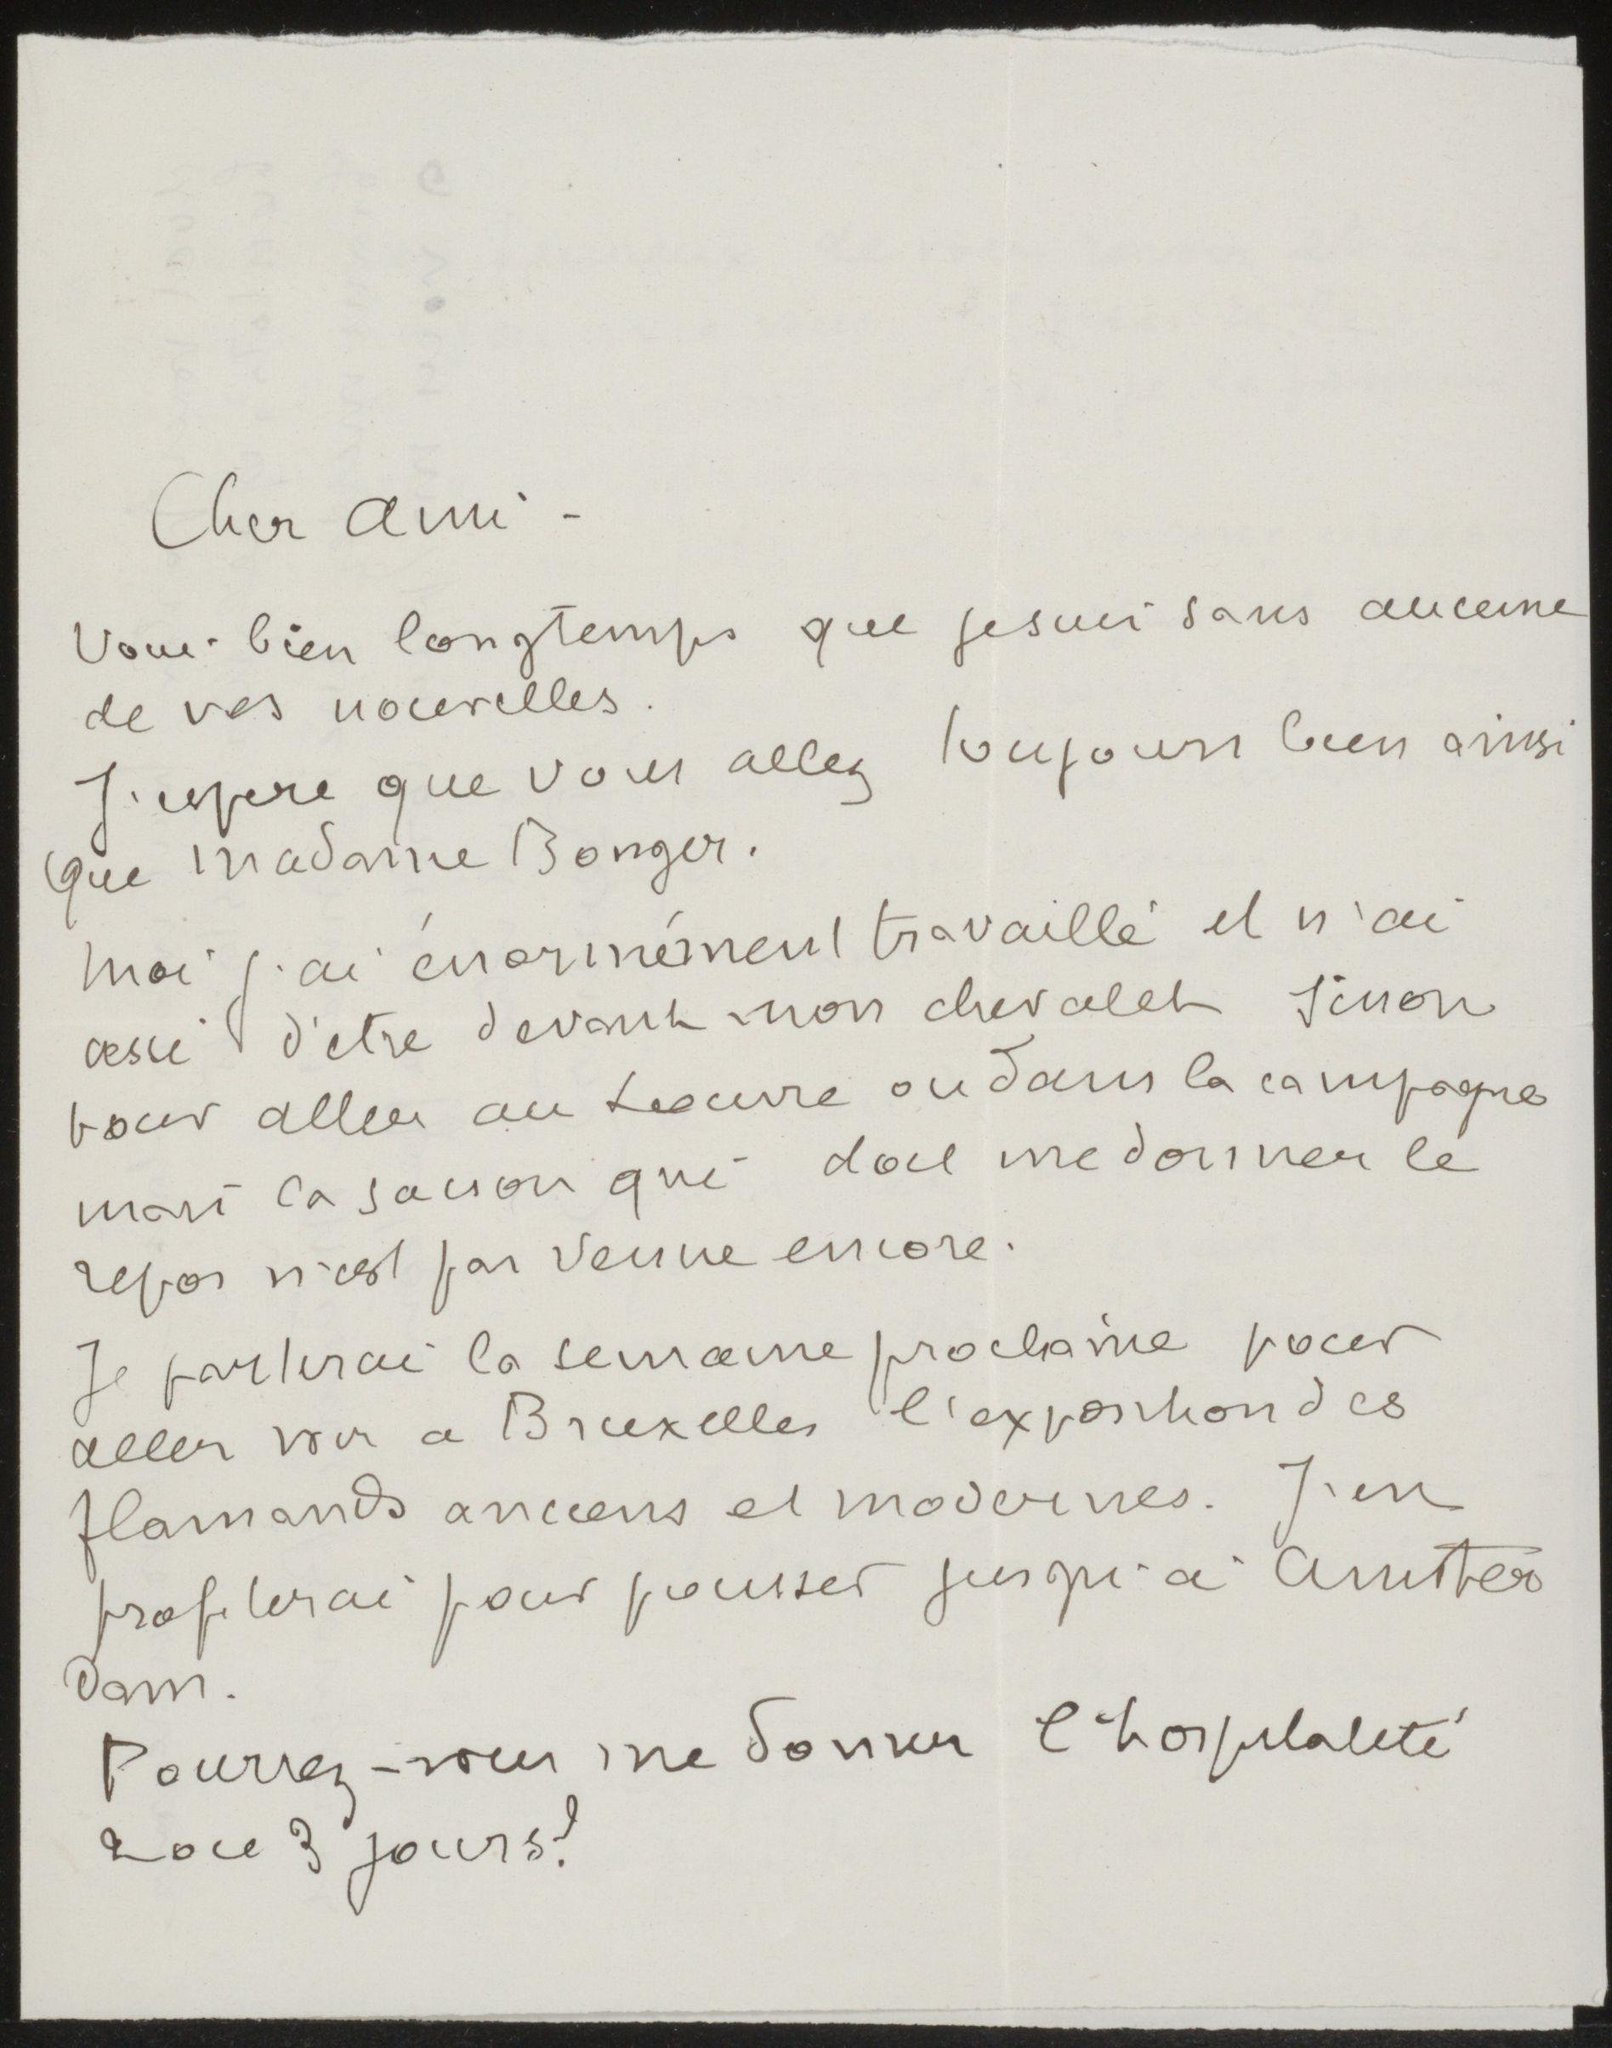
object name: letter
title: Brief aan Andries Bonger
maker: émile bernard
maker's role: print maker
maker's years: 1868-1941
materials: ink, paper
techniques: pen, writing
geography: paris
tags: painter, draughtsman, vincent van gogh, amsterdam, andries bonger, exhibition ~ art, printed matter, brussels